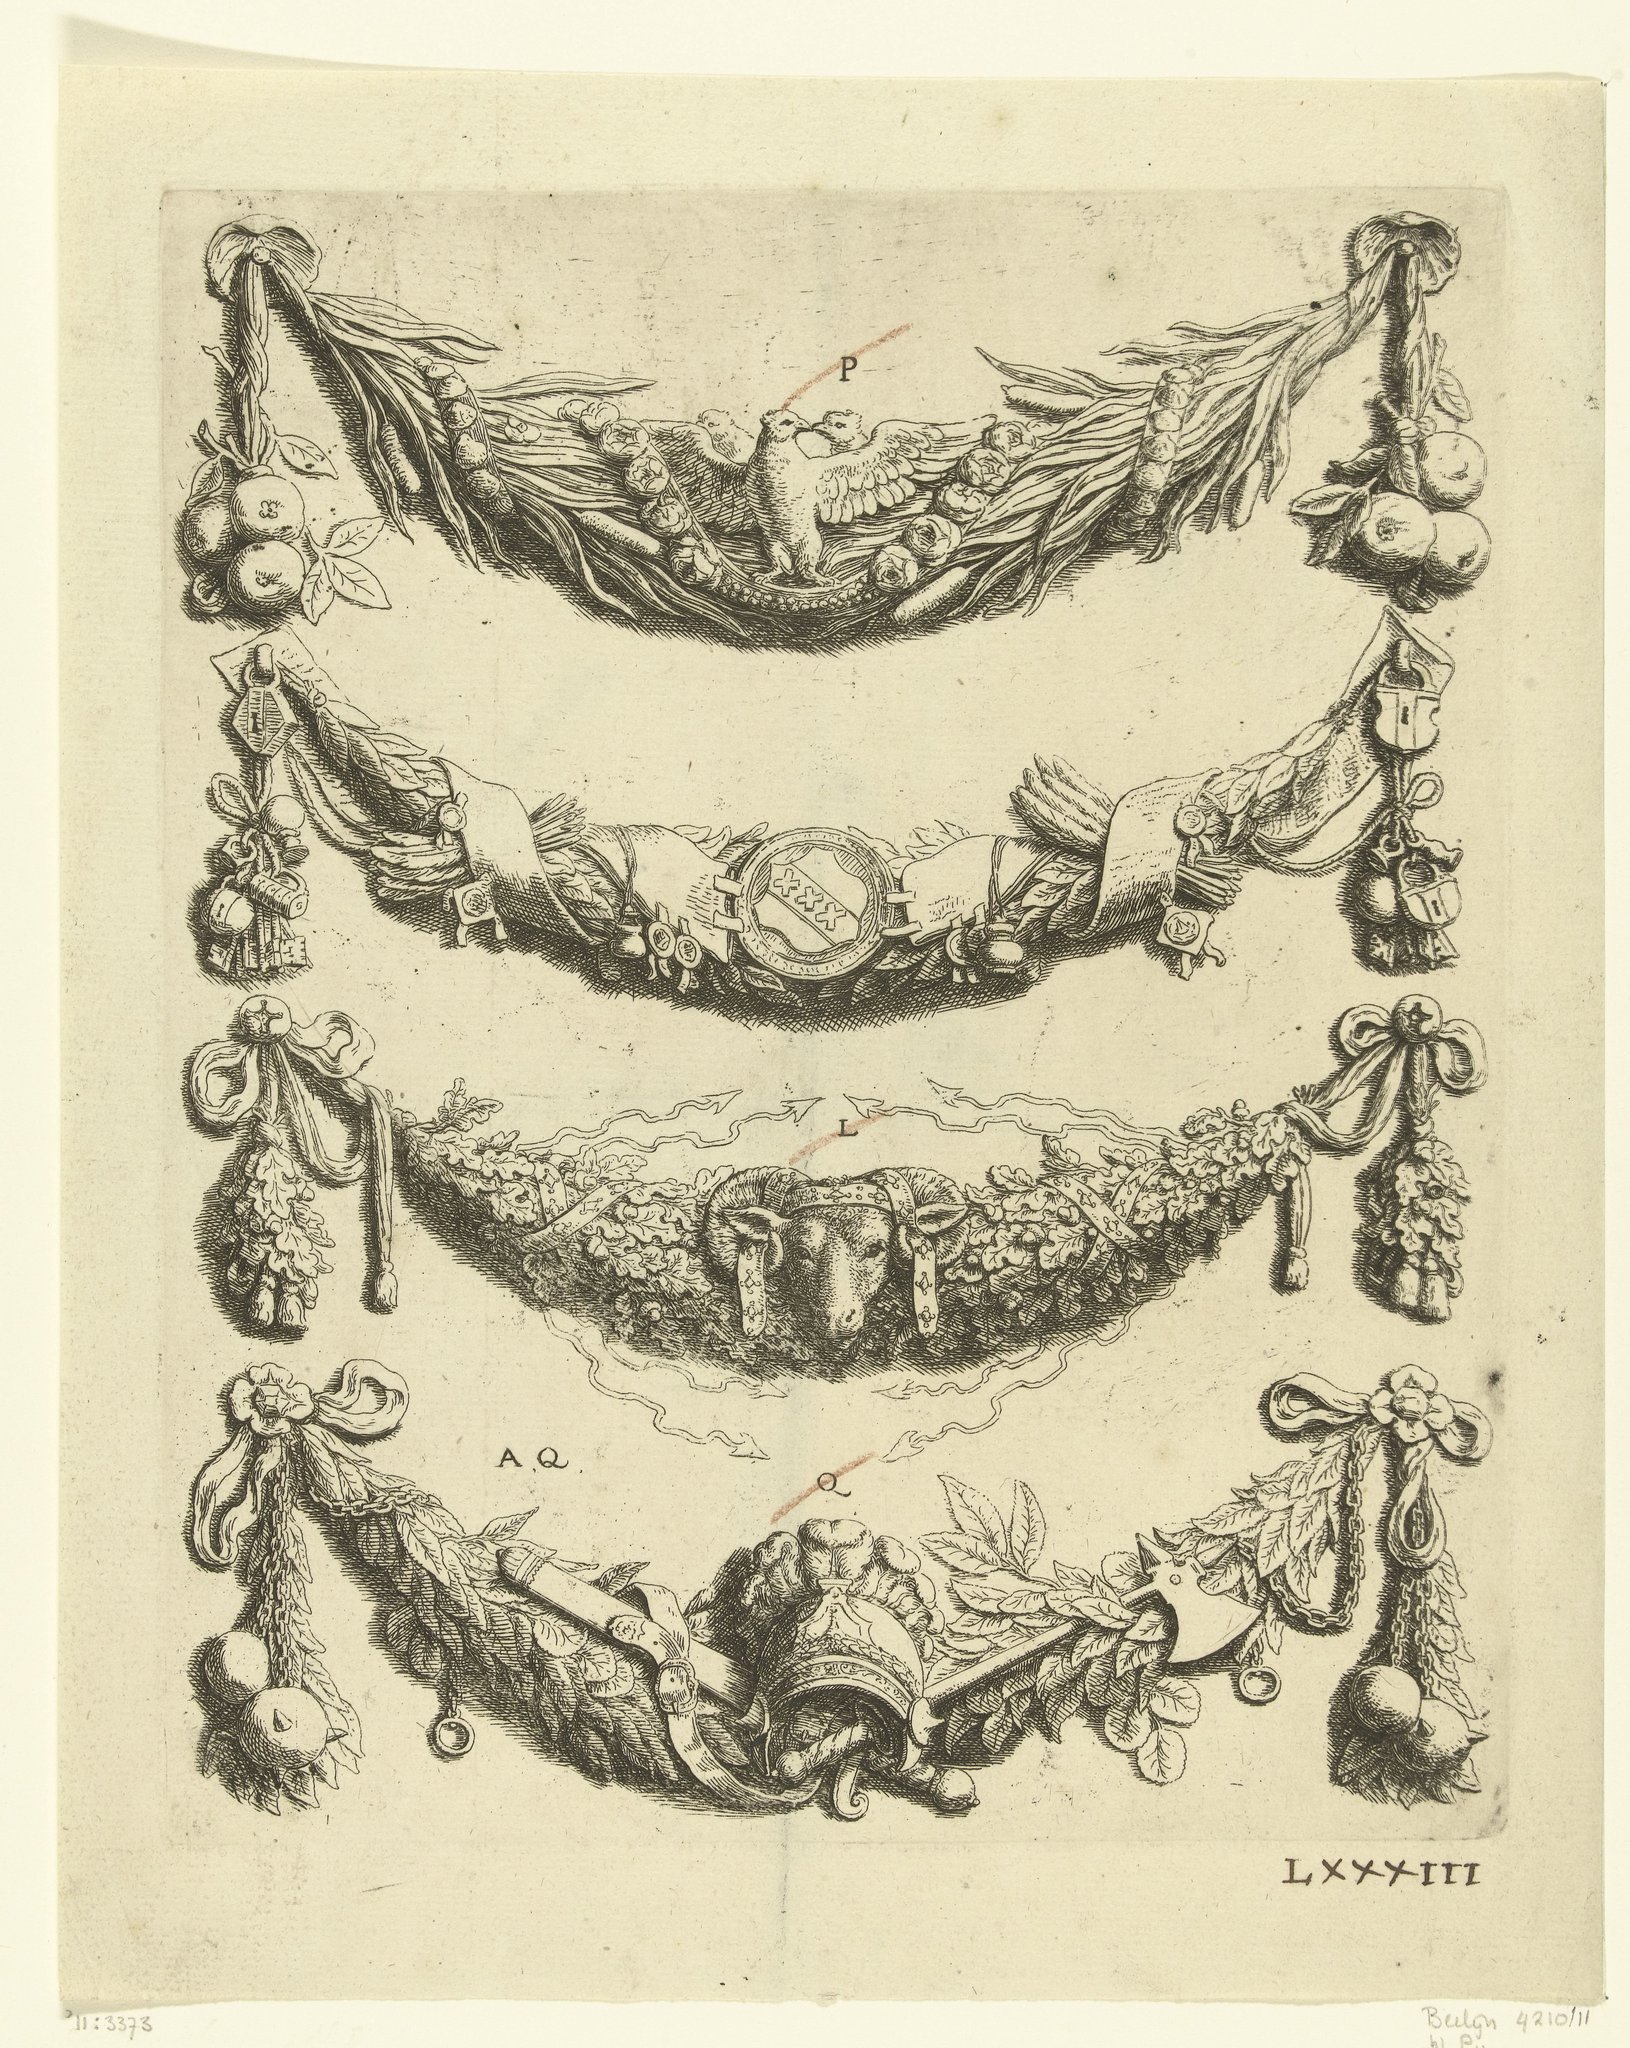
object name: print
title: Vier festoenen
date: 1665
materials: paper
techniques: etching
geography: amsterdam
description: Festoenen met in het midden twee duiven, het wapenschild van Amsterdam, kop van een ram en een helm met pluimen. Blad P [4]. Blad uit tweede editie.